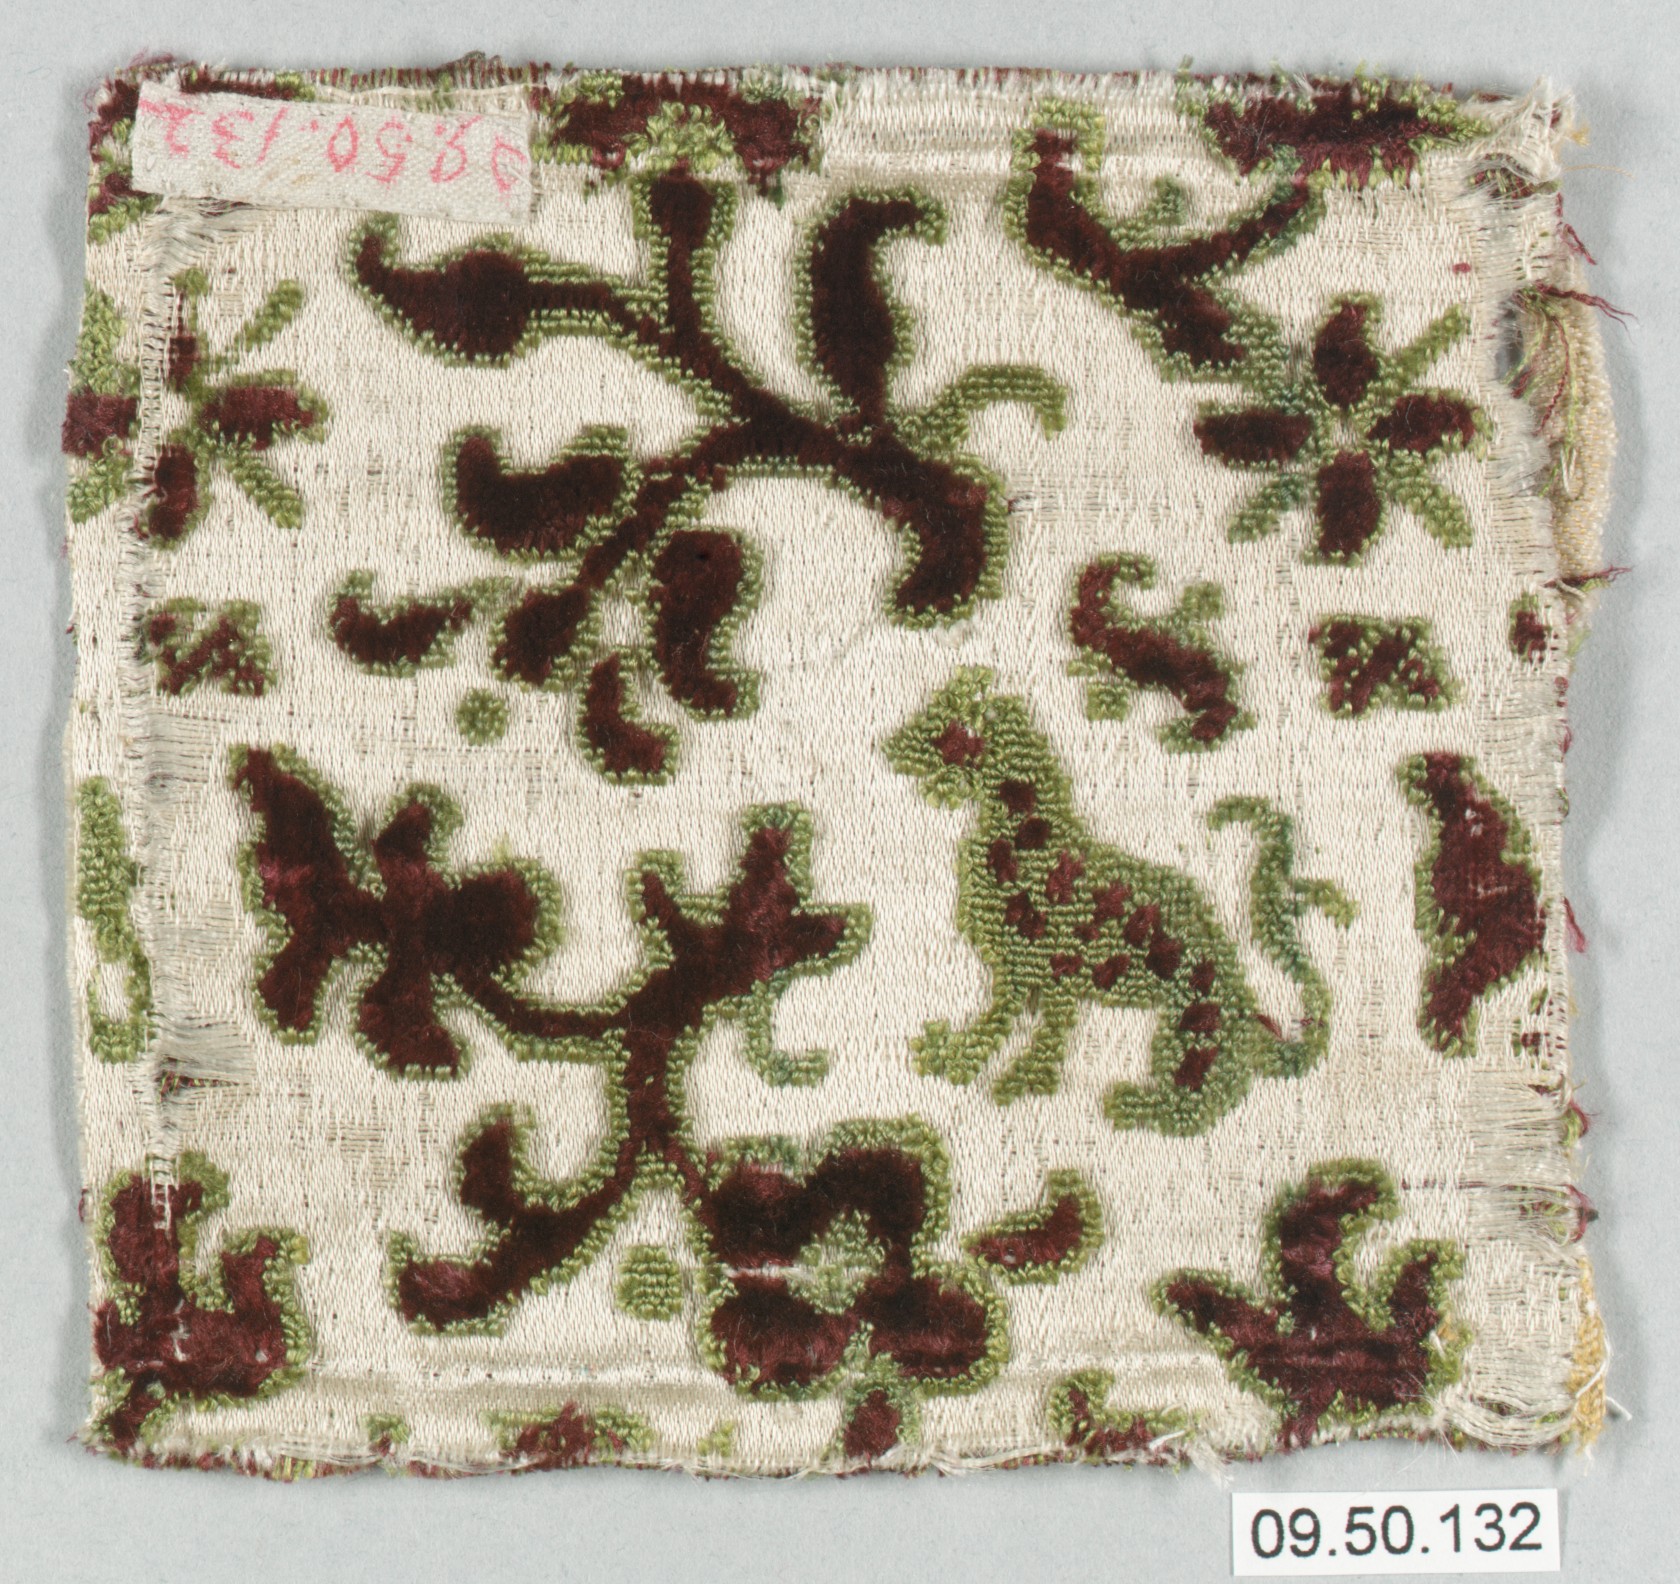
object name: velvet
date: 1501-1700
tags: animals